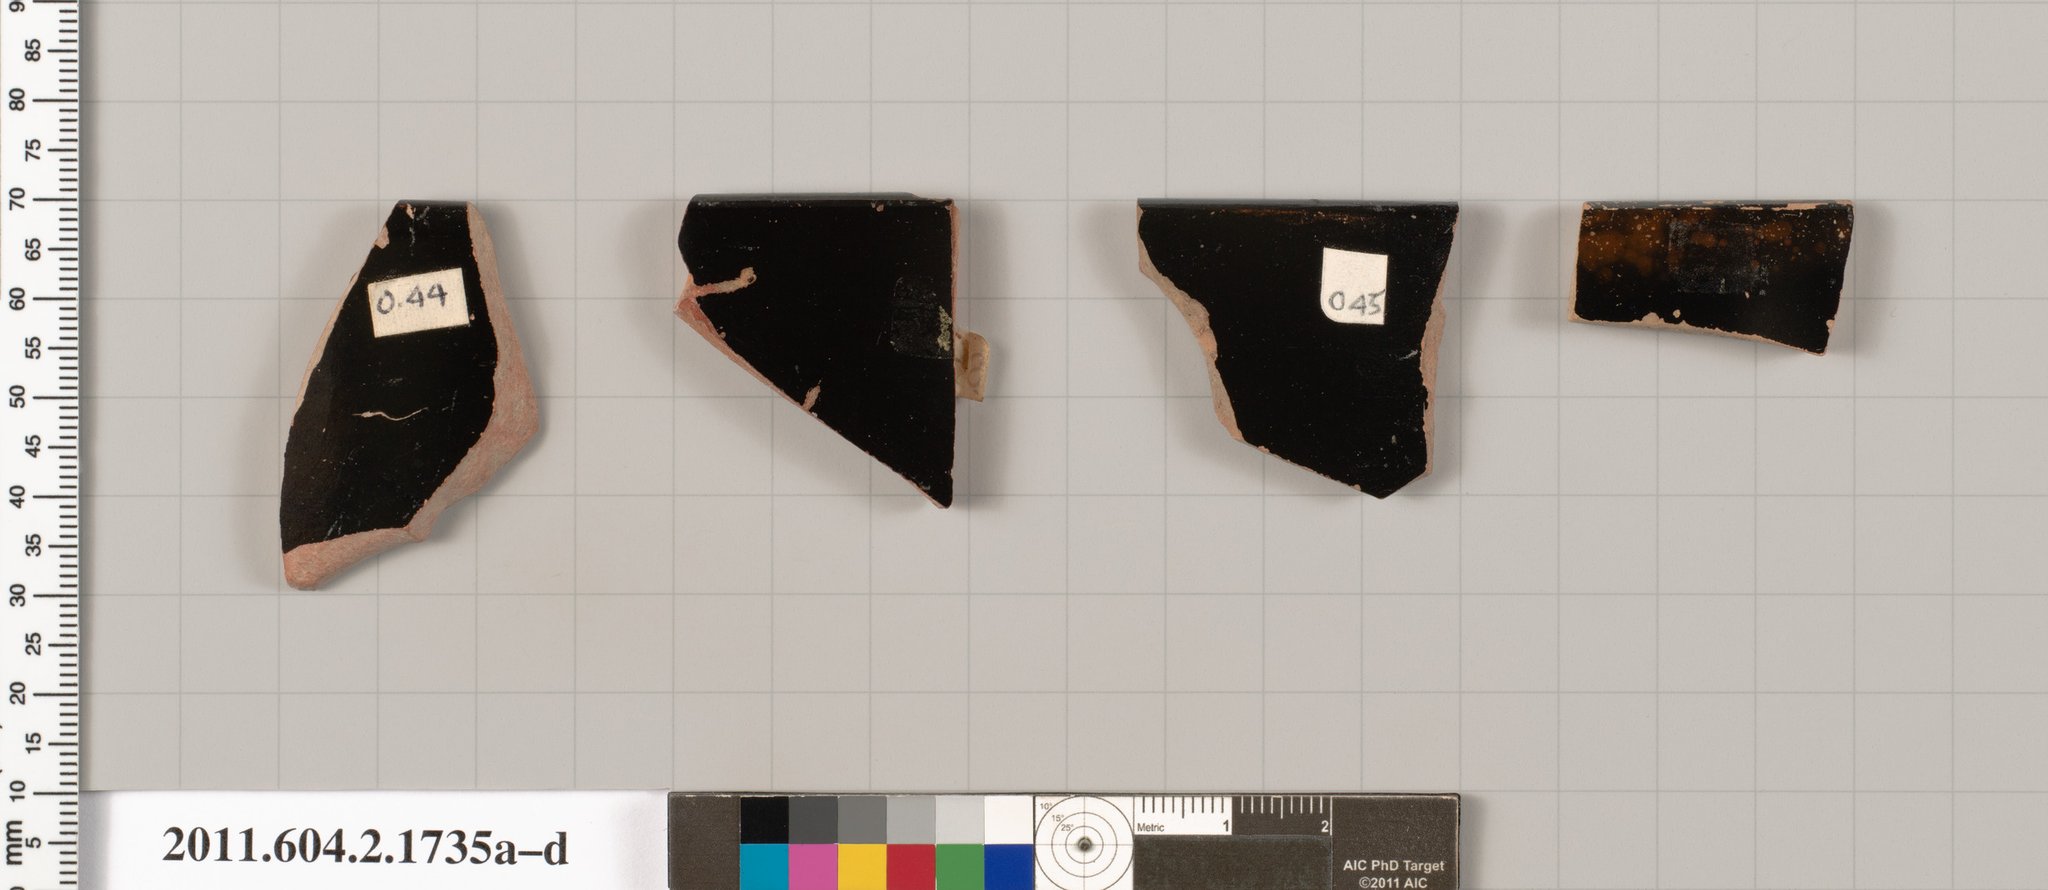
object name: skyphos fragment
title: Terracotta rim fragments of skyphoi (deep drinking cups)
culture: greek, attic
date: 475-451 BCE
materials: terracotta